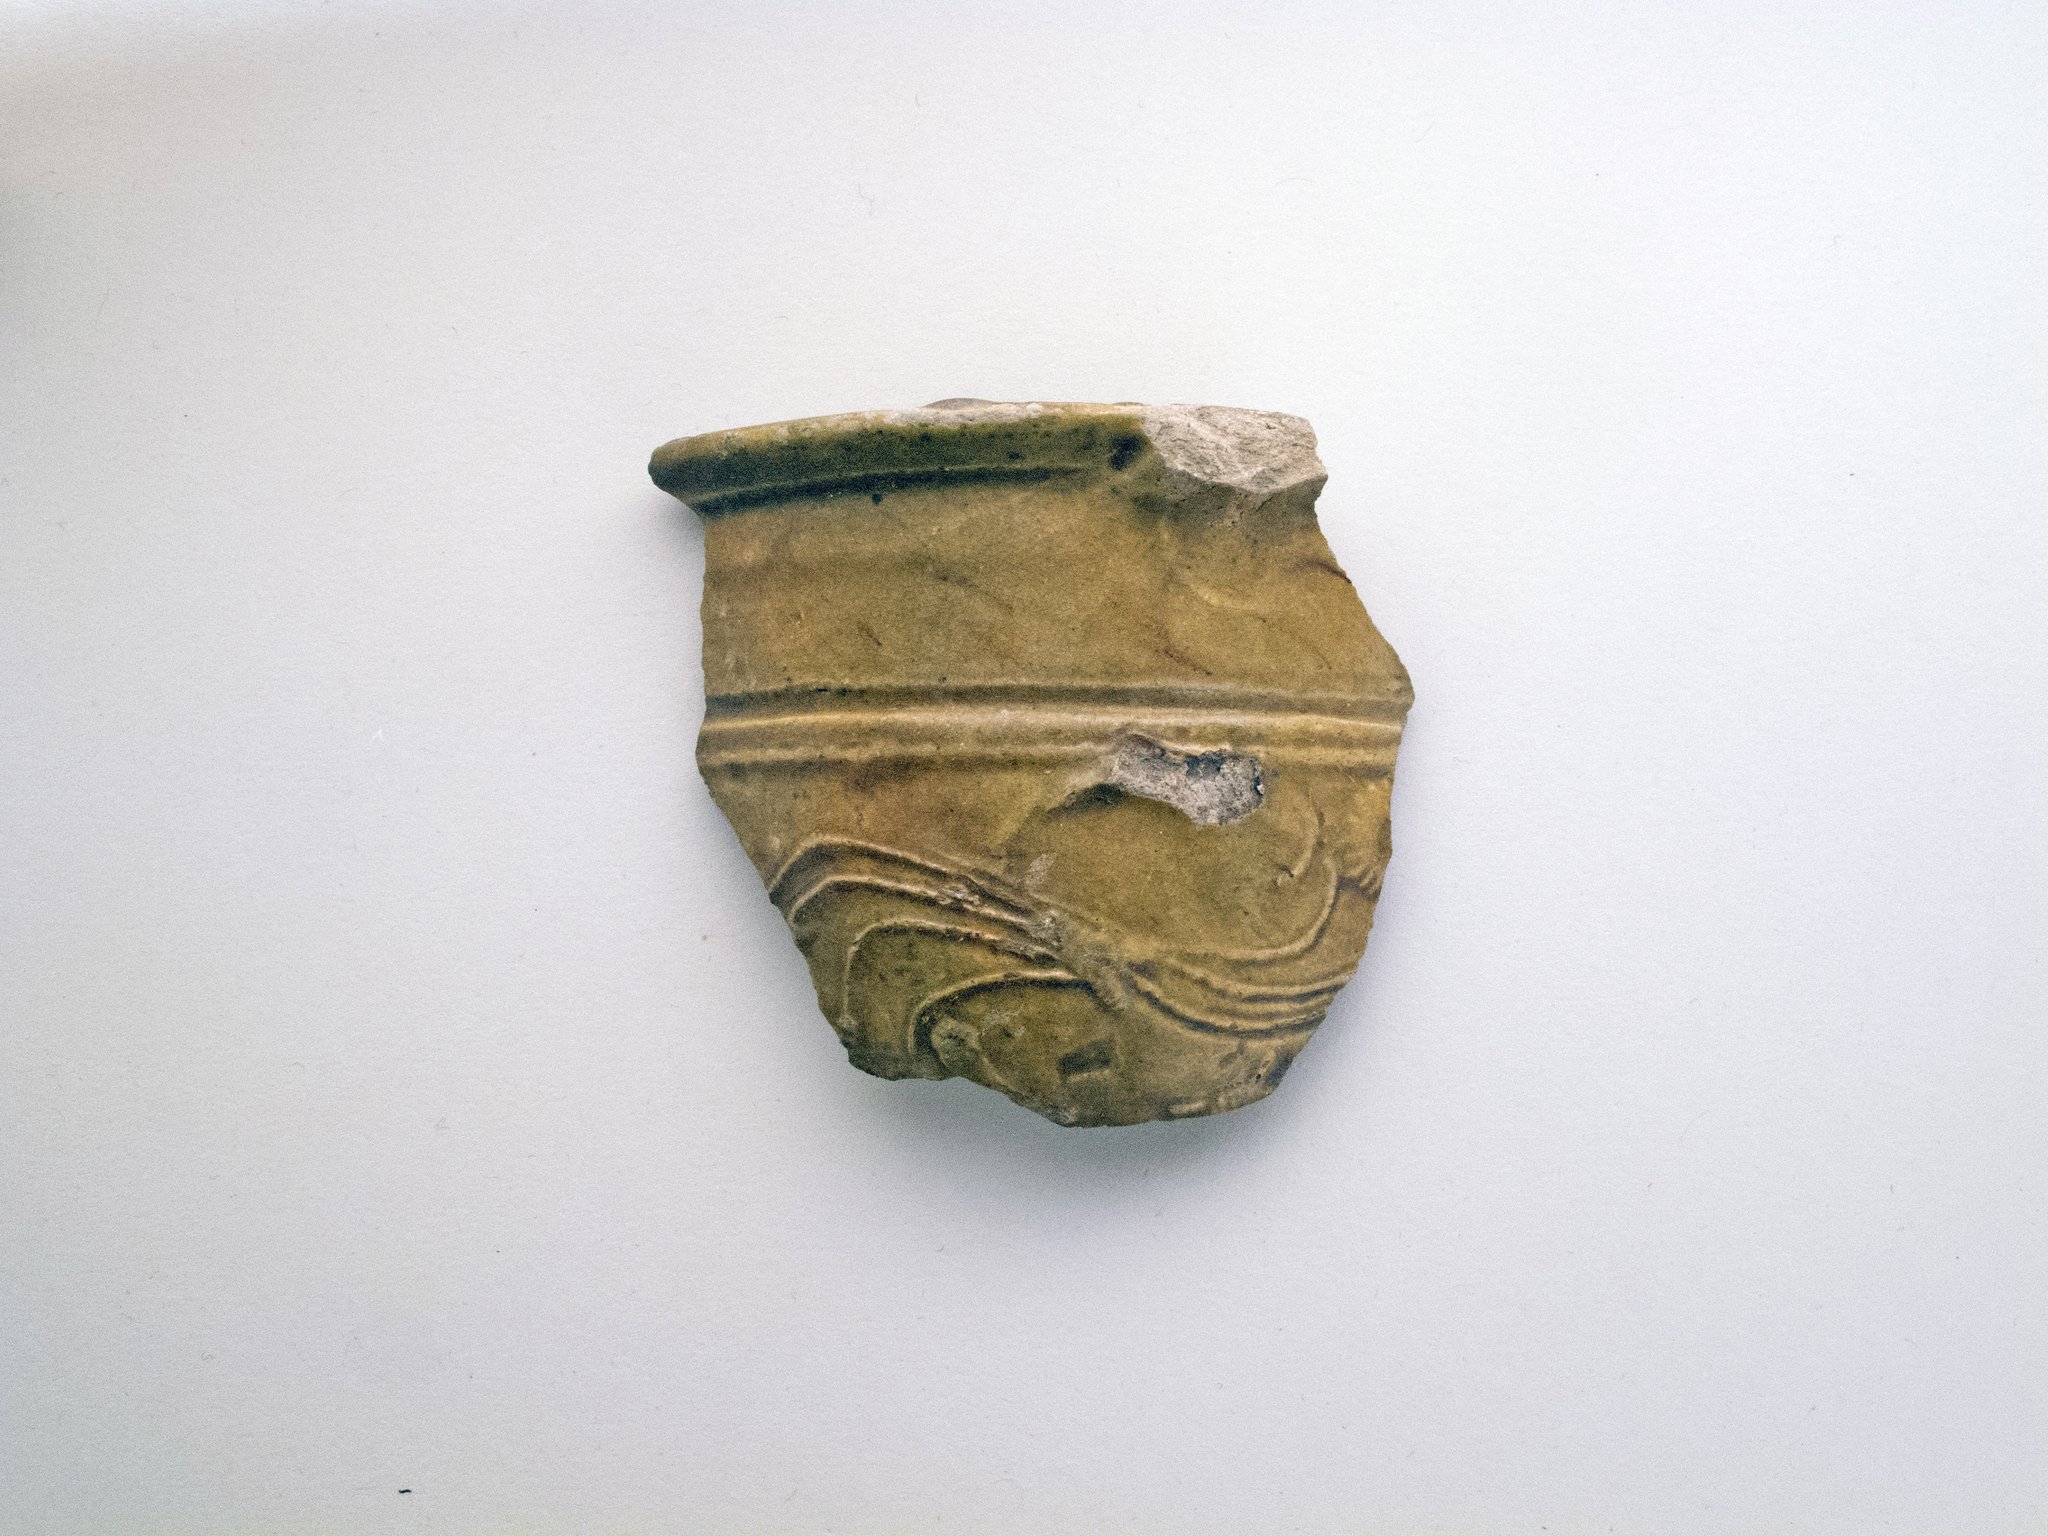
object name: vase fragment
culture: roman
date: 670 BCE-330 CE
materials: terracotta